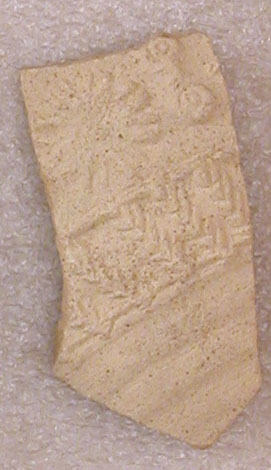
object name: fragment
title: Molded Ceramic Fragments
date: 801-900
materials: earthenware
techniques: incising, molding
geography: iraq